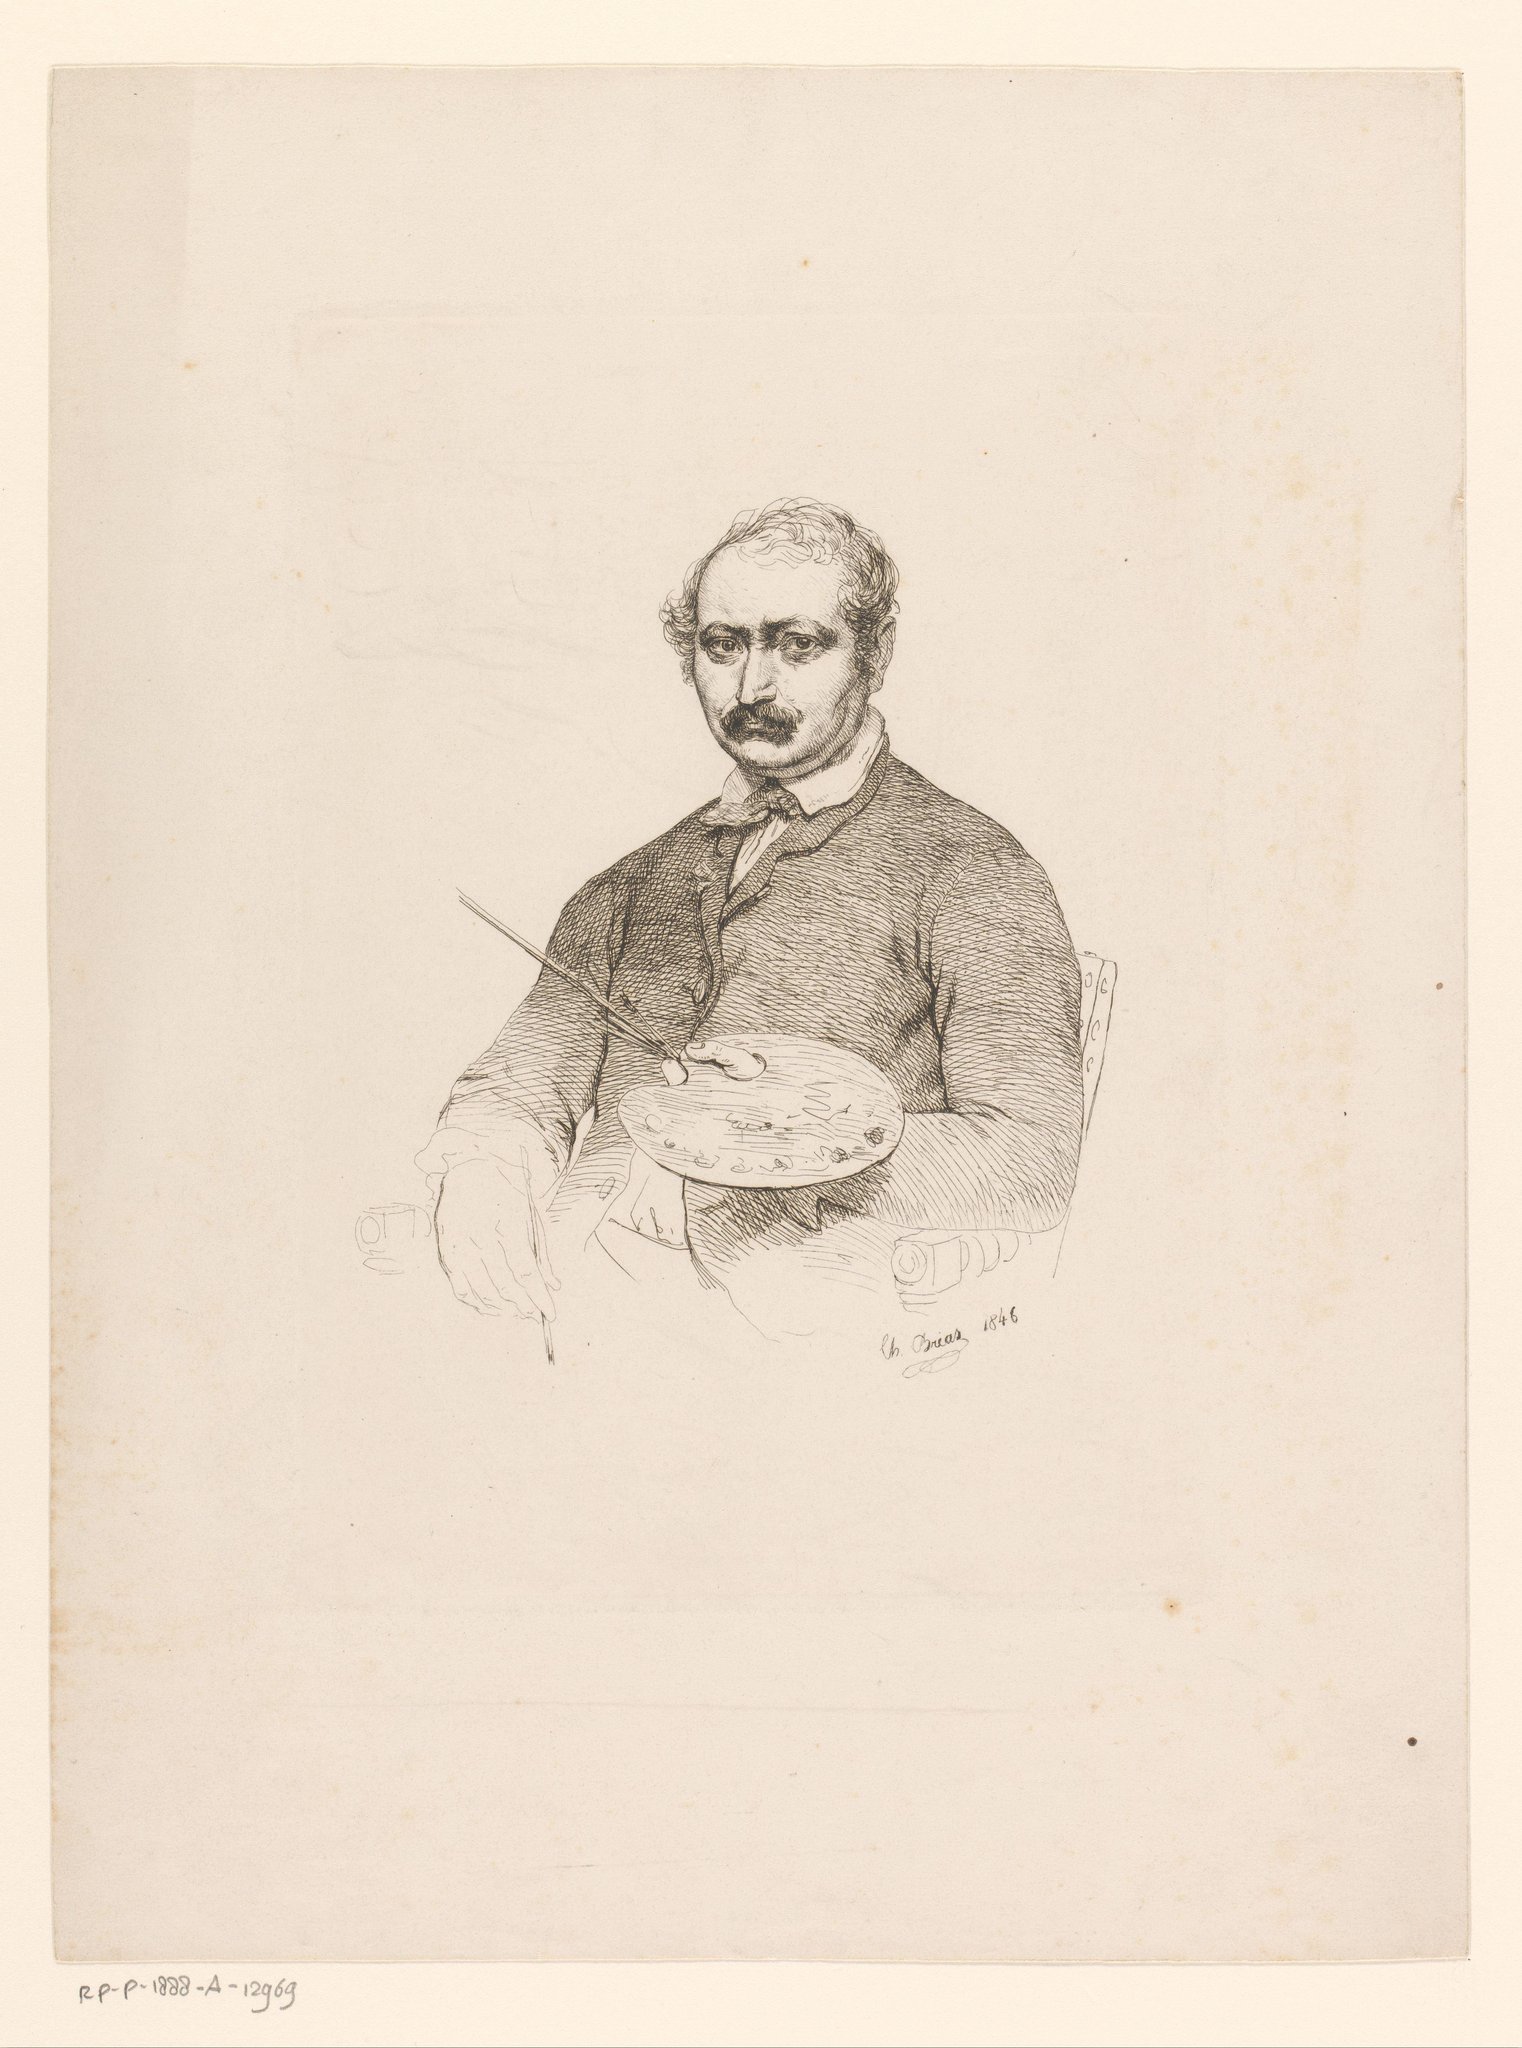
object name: print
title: Zelfportret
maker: charles brias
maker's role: draughtsman, print maker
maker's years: 1798-1884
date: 1846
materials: paper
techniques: etching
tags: mechelen, brussels, print maker, draughtsman, charles brias, historical persons, portrait, self-portrait of painter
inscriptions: collector's mark: Lugt 2228